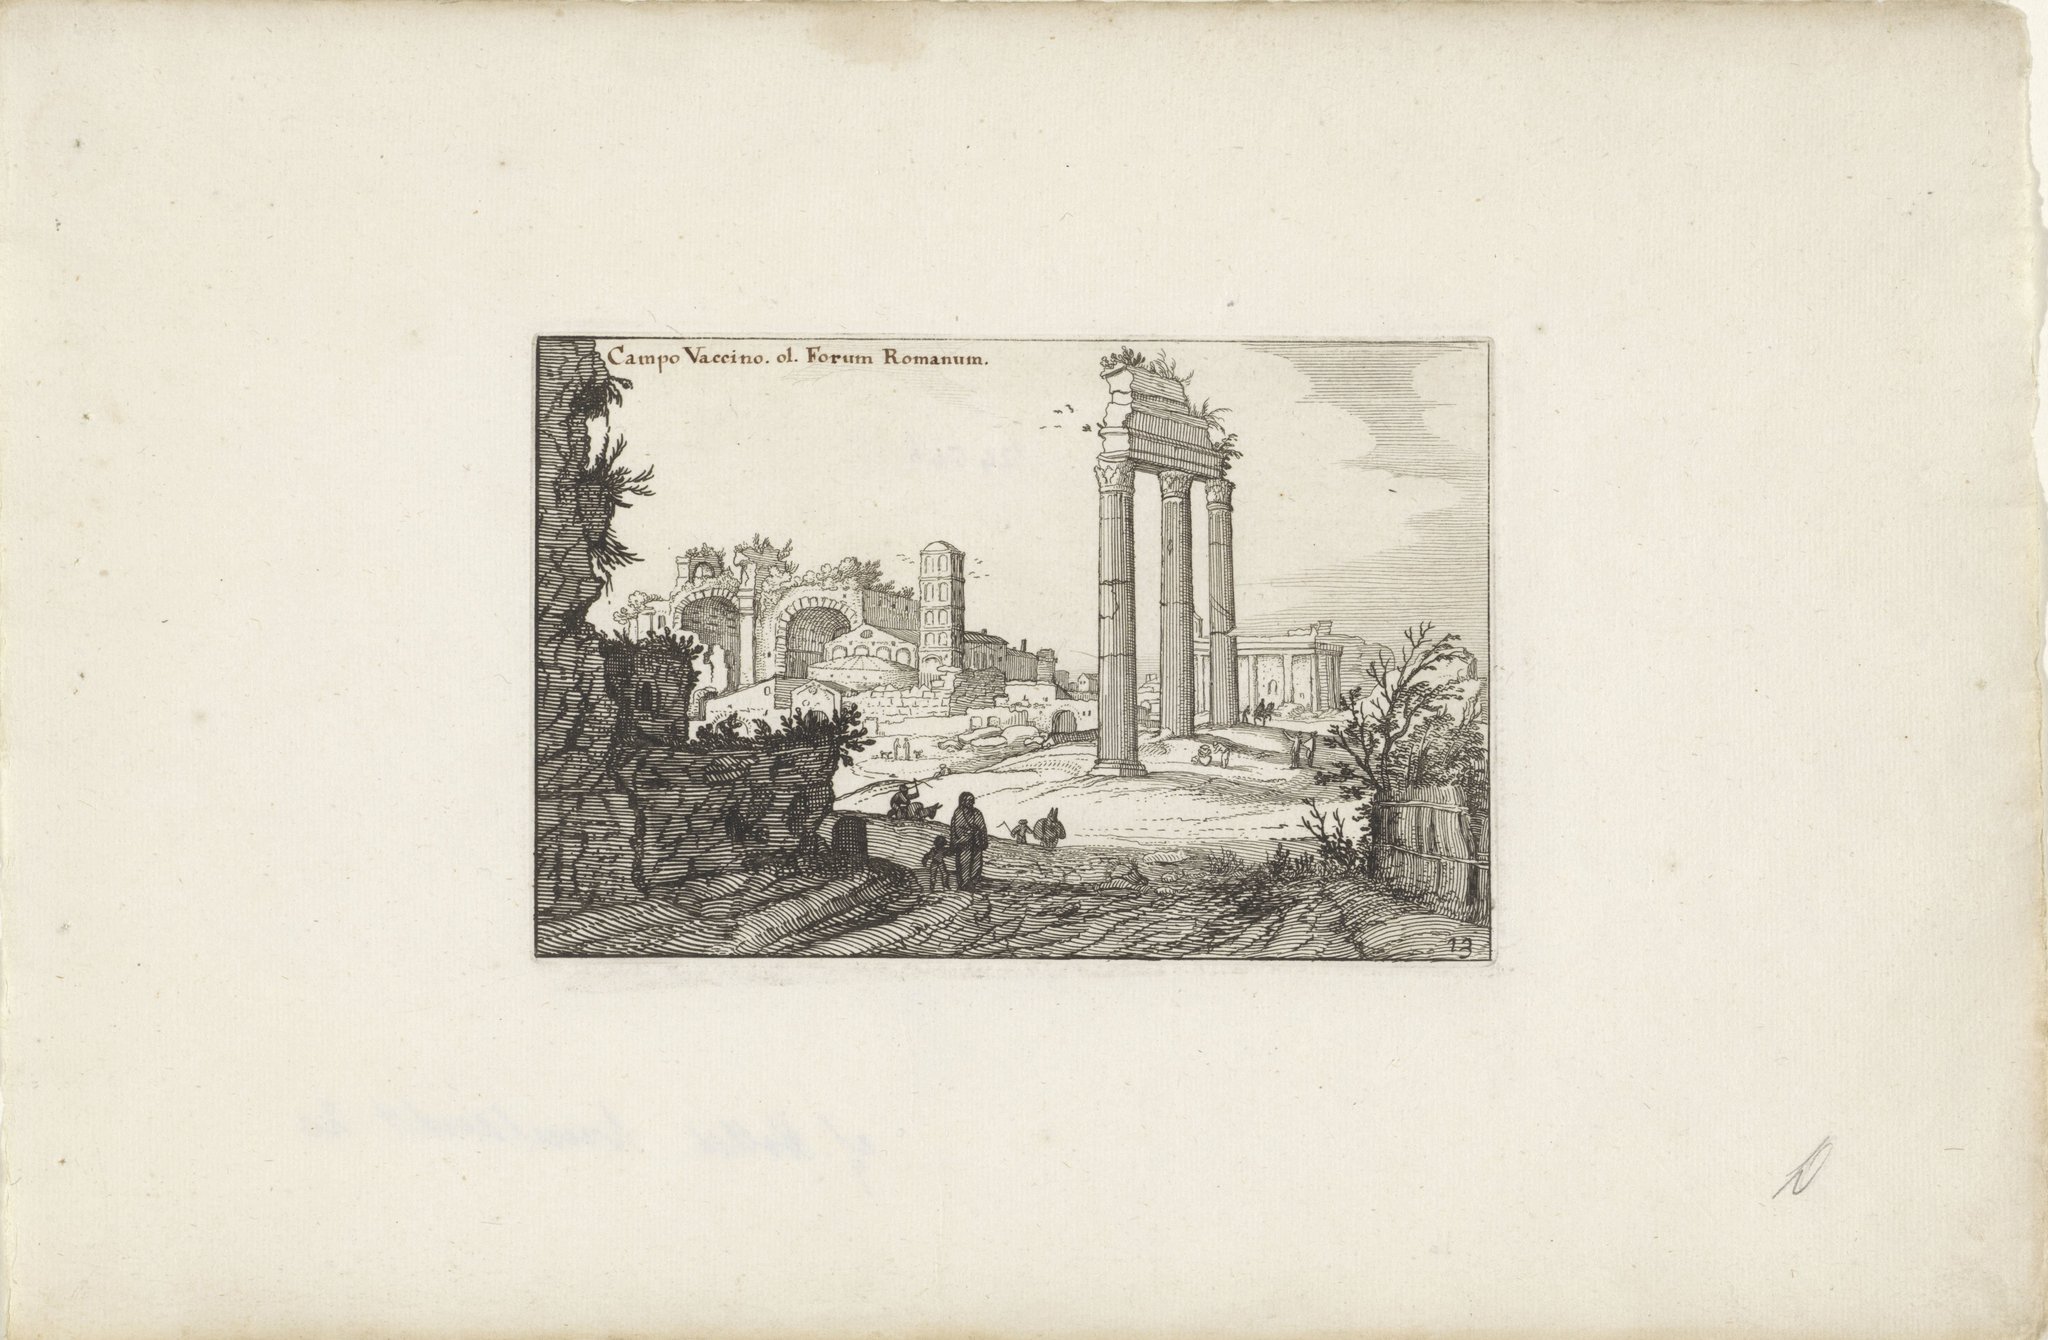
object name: print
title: Tempel van Castor en Pollux en de Basiliek van Constantijn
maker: claes jansz. visscher (ii)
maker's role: draughtsman, print maker, publisher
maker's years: 1586-1652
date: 1618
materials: paper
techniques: etching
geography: amsterdam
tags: public baths, temple, shrine ~ roman religion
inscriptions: collector's mark: Lugt 2233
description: Gezicht op de tempel van Castor en Pollux en de Basiliek van Constantijn op het Forum Romanum te Rome. Op de voorgrond enkele figuren.